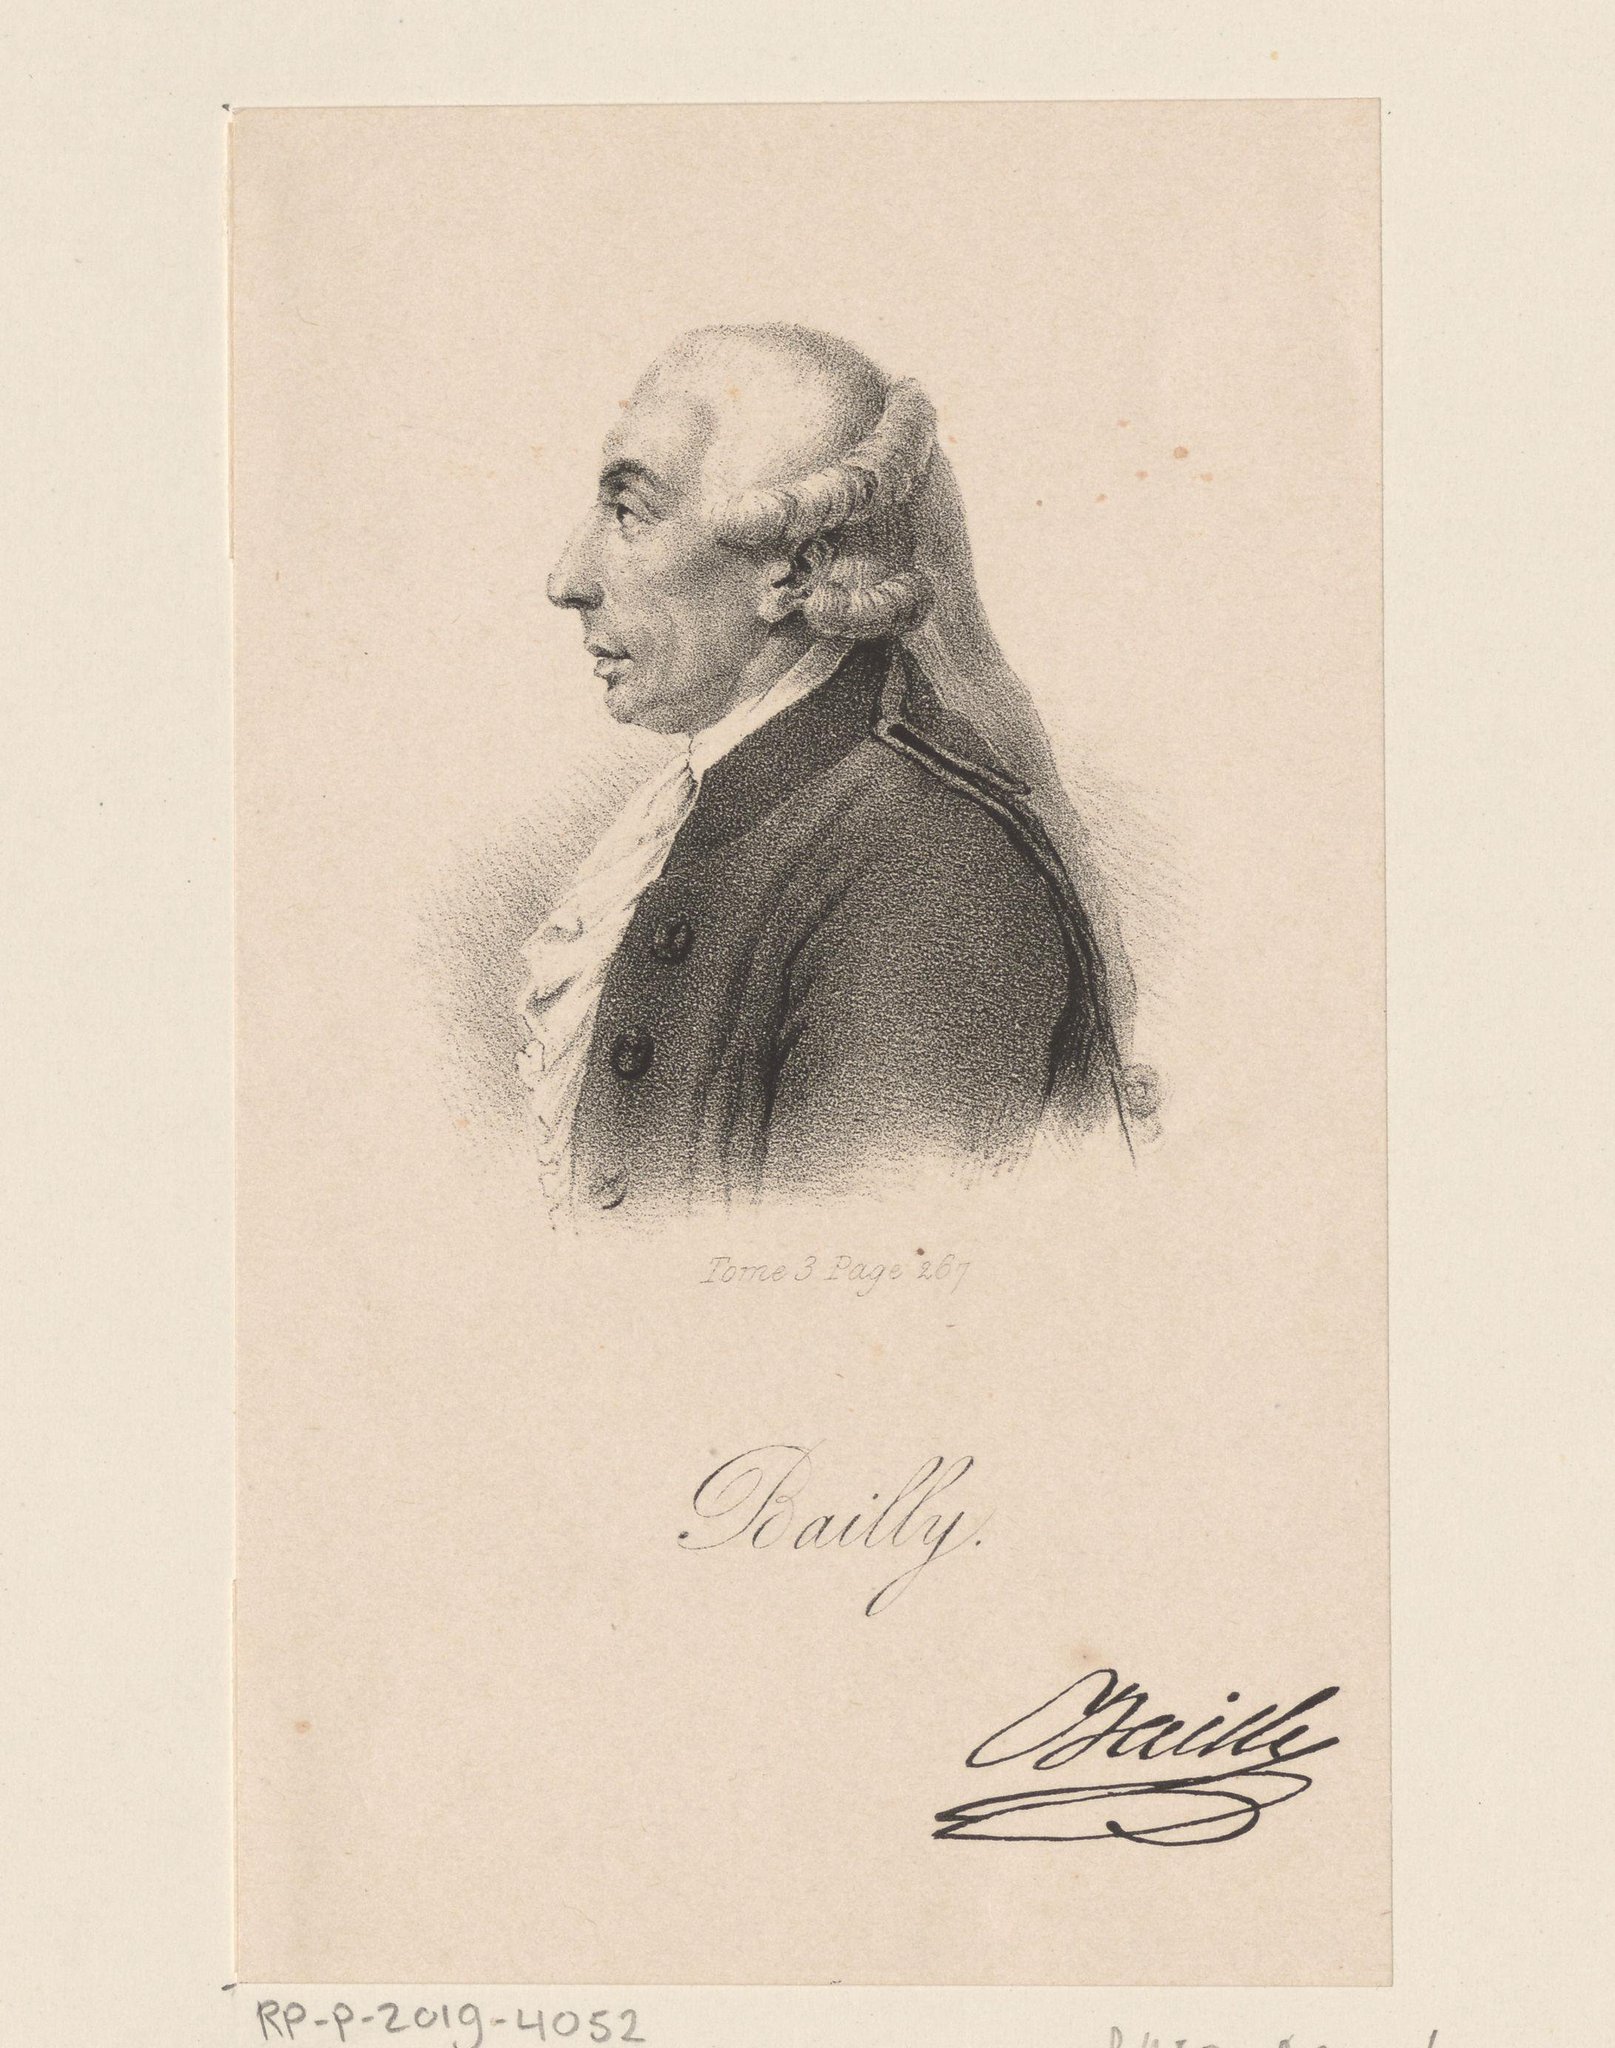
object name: print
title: Portret van Jean Sylvain Bailly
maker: Anonymous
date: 1800-1849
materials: paper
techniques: lithograph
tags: paris, politician, mayor, historical persons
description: Onder het portret genummerd: Tome 3 Page 267.